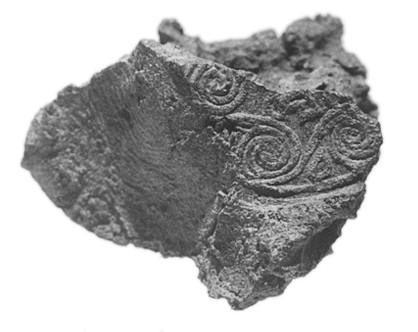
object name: sealing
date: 2030-1640 BCE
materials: clay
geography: egypt